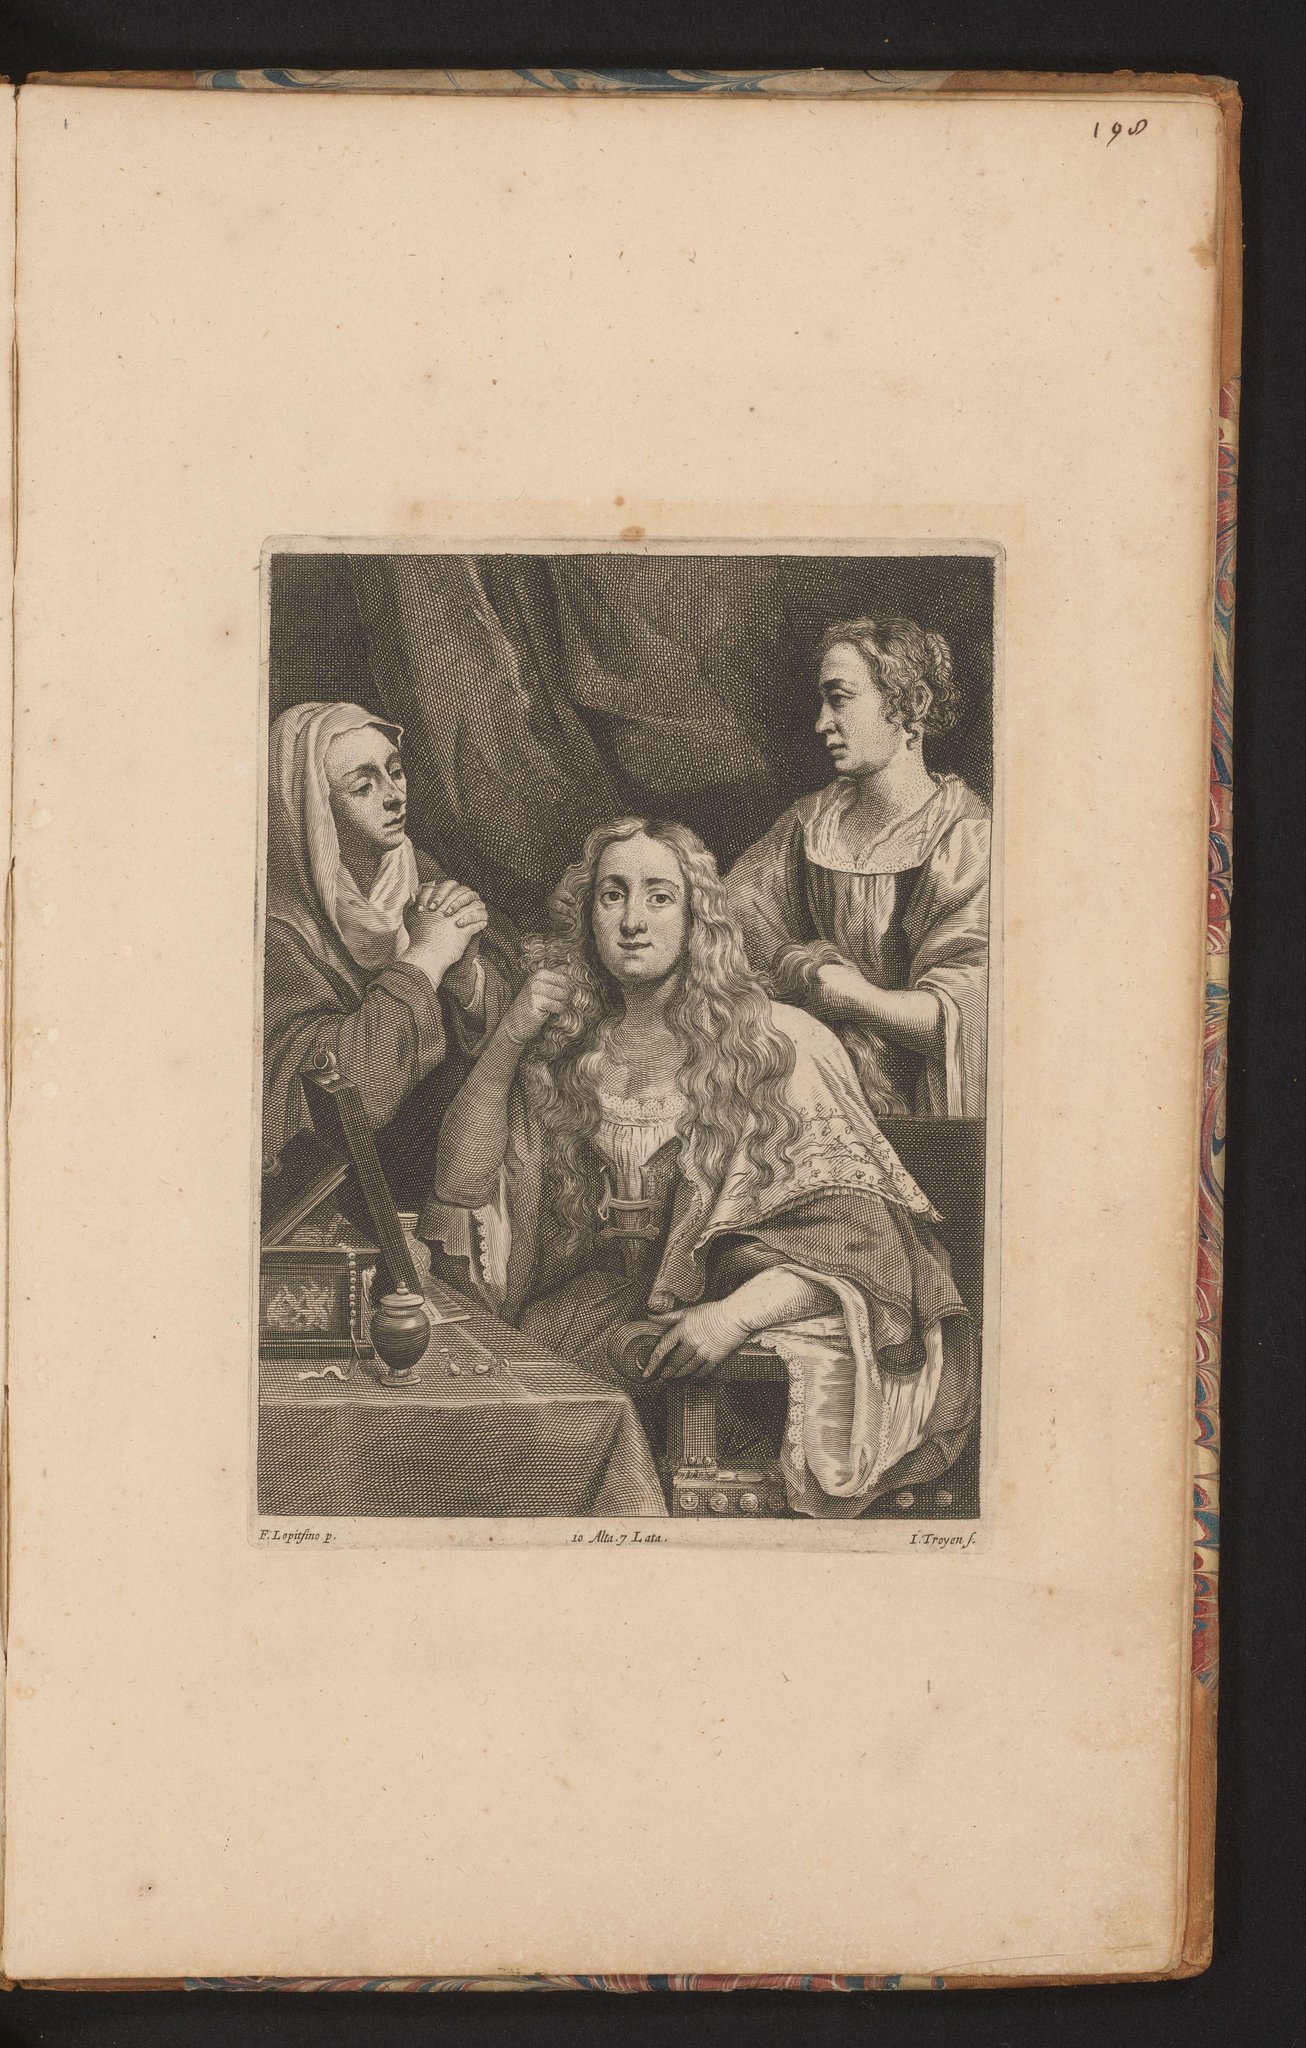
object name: album leaf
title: Marta wijst Maria Magdalena terecht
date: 1660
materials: paper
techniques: engraving, etching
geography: brussels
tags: st. martha rebuking her sister mary magdalene for her vanity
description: De prent is vervaardigd naar het schilderij van Lupicini dat zich in de collectie van het Kunsthistorisches Museum te Wenen bevindt (inventarisnummer GG_364). David Teniers heeft waarschijnlijk van alle schilderijen uit de collectie van Leopold Willem van Oostenrijk een olieverfstudie op doek of paneel vervaardigd (zgn. pasticcio), die als voorbeeld voor de prentmakers diende. Het is niet altijd duidelijk of de pasticci door hem zijn gemaakt of door zijn atelier. Niet alle pasticci zijn overgeleverd.